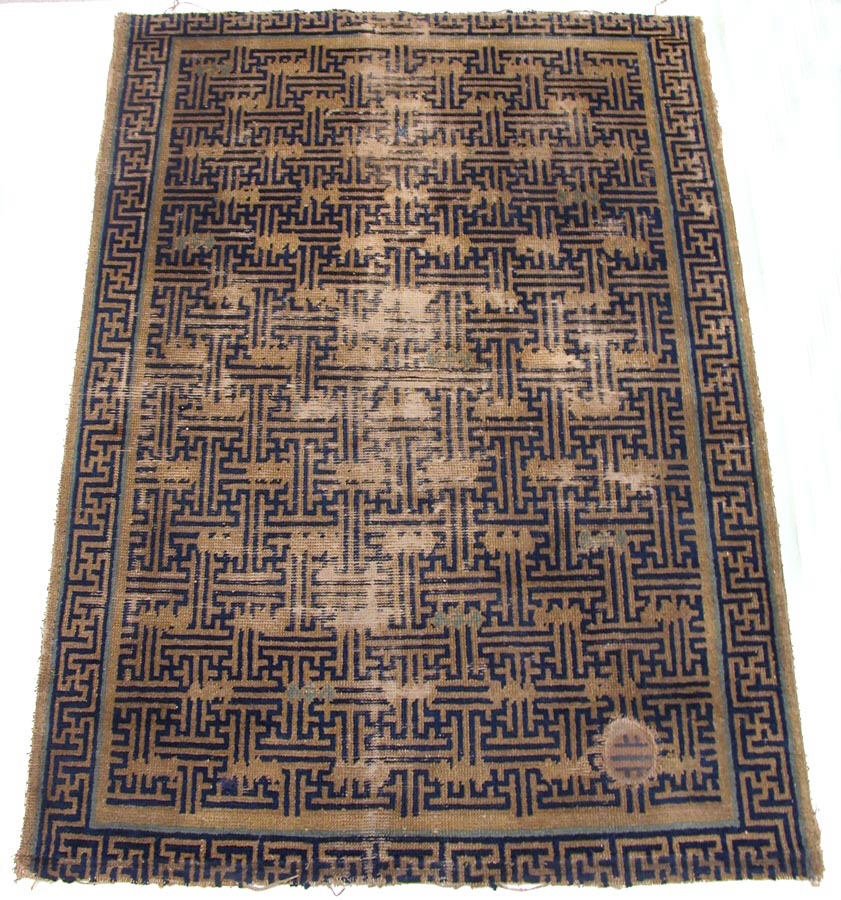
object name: kang rug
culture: chinese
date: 1601-1700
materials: cotton, wool